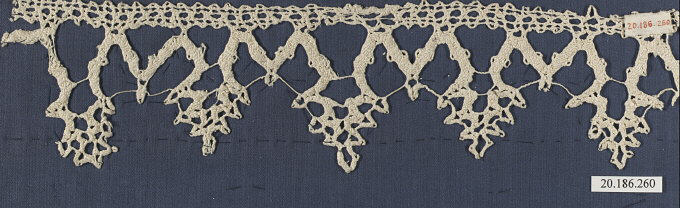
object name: edging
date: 1501-1700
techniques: lace